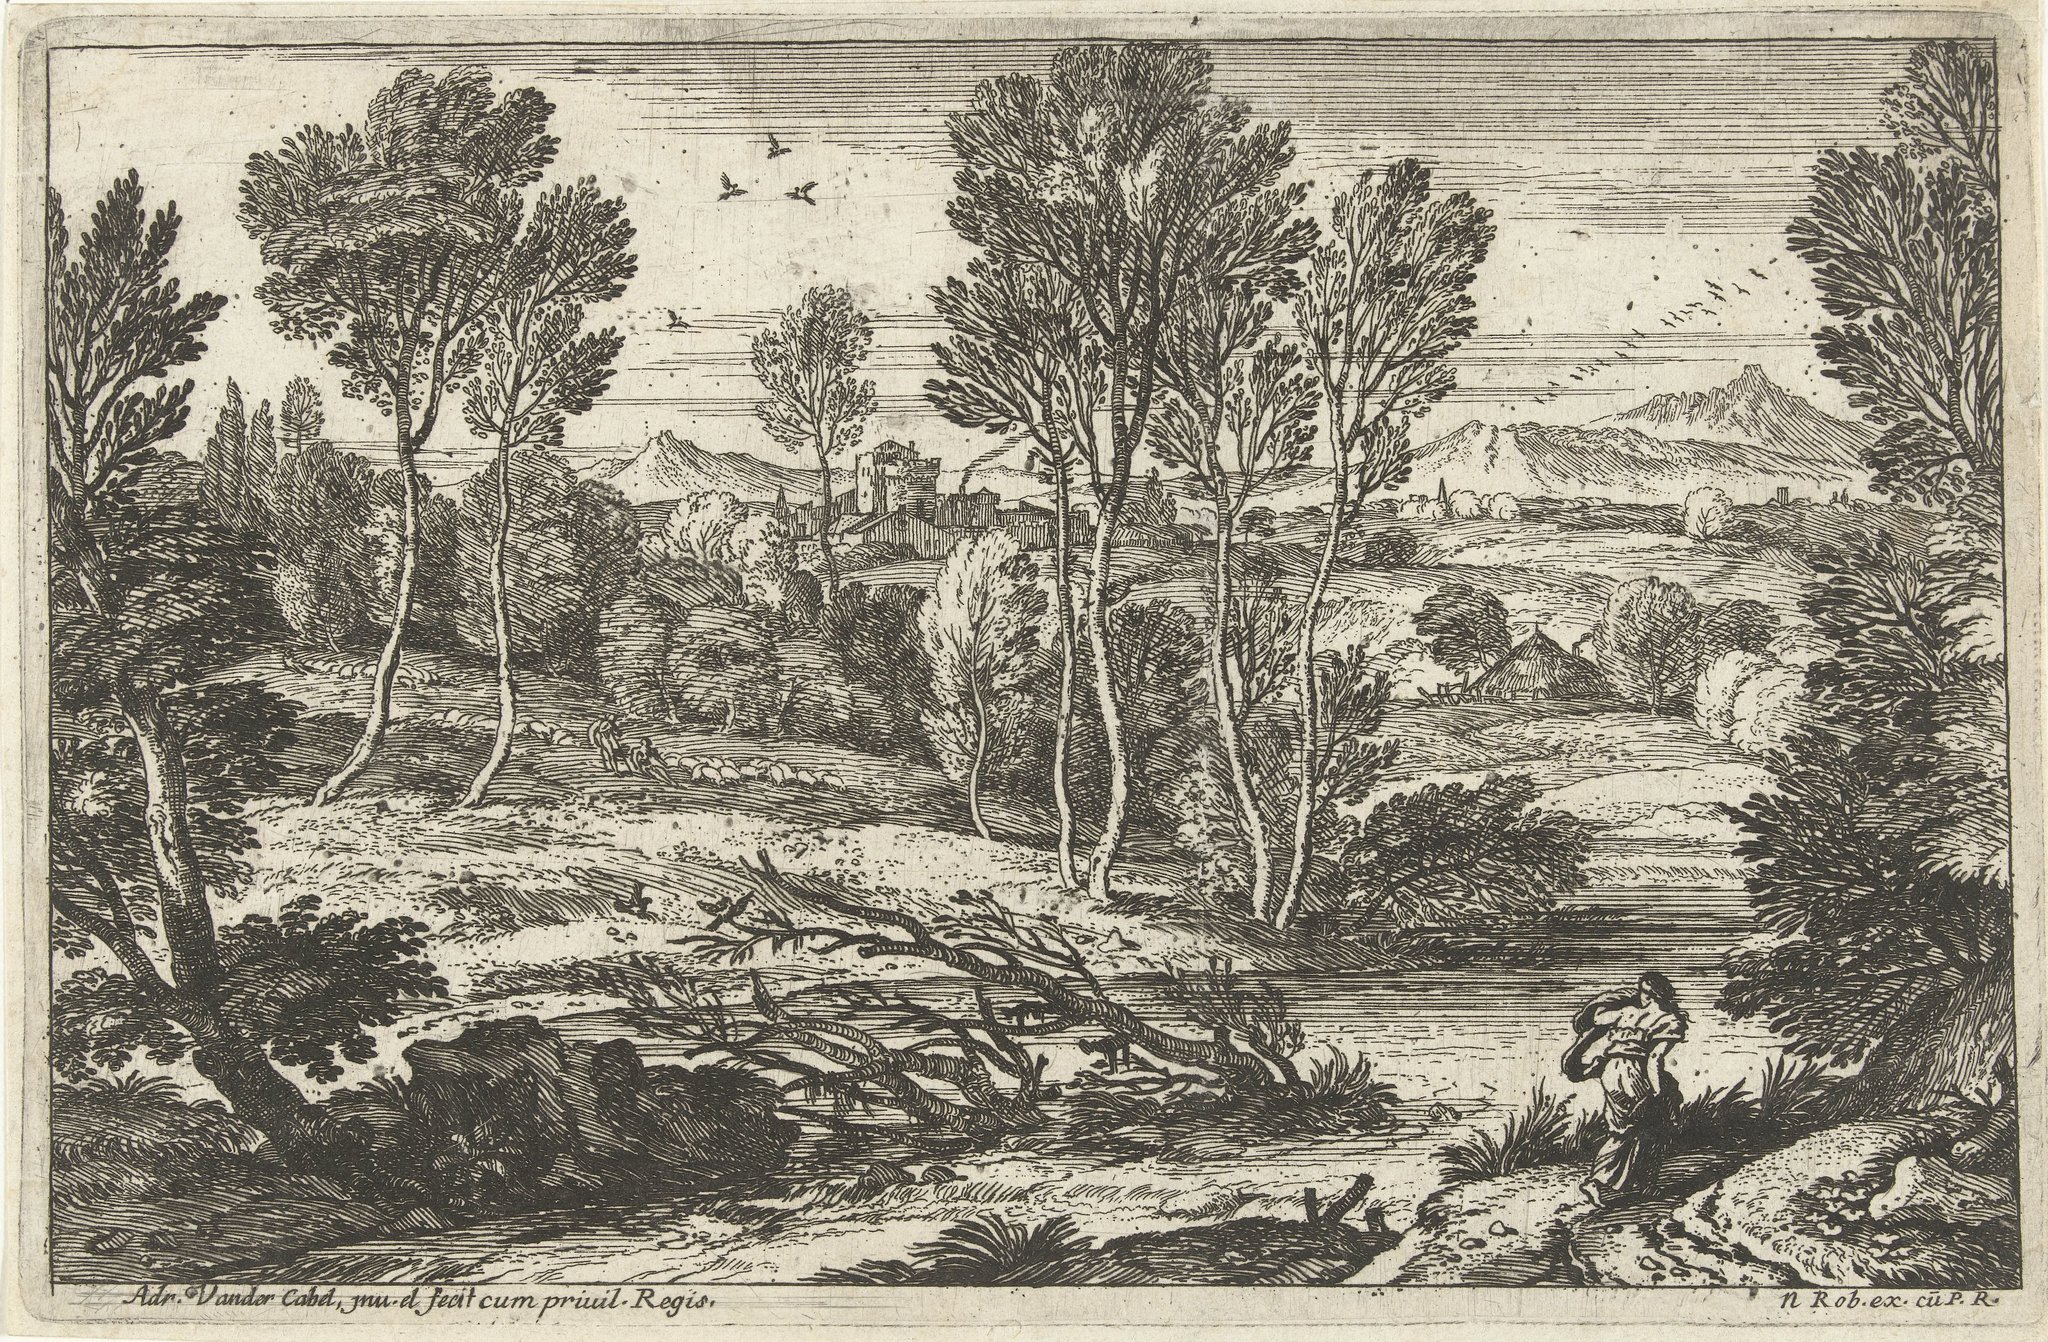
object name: print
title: De gehaaste vrouw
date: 1648-1705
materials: paper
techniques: etching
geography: france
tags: landscapes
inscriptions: collector's mark: Lugt 2228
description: Vrouw met opbollende sjaal over linker arm, lopend langs rivier waarin omgevallen bomen. Aan de overkant van de rivier twee personen bij een kudde schapen. Eerste prent uit de serie van zes.